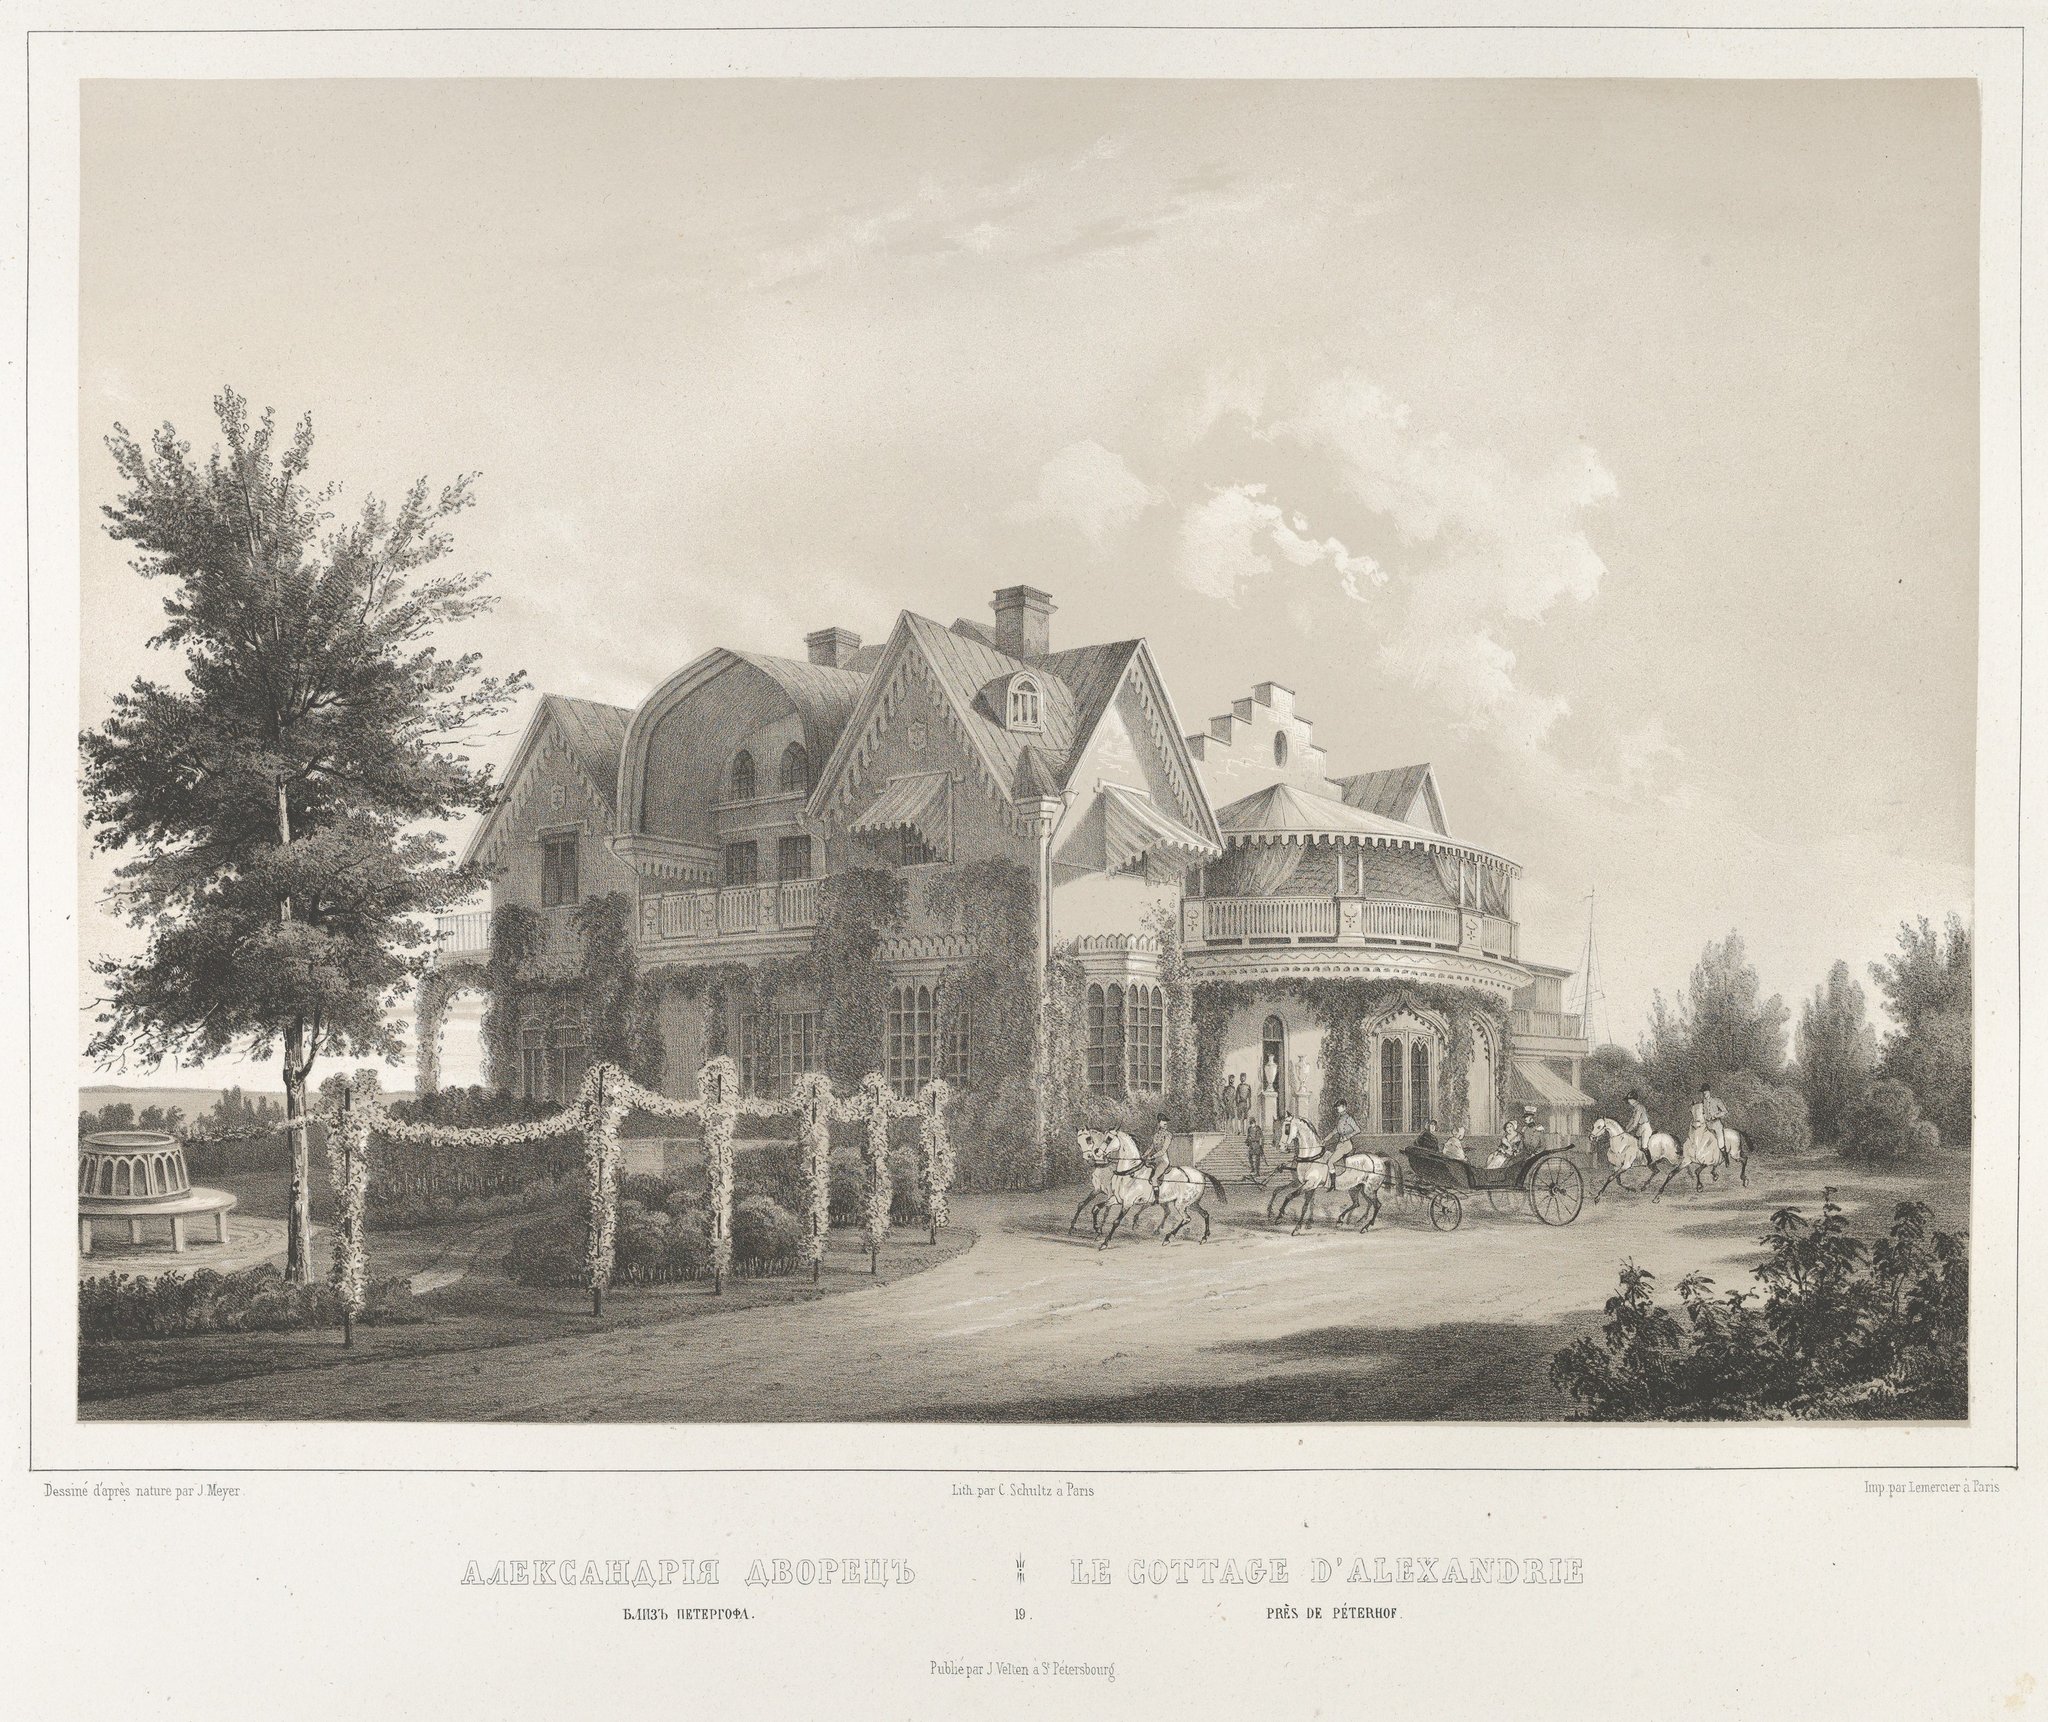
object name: print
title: Le Cottage D'Alexandrie près de Péterof, from "Vues pittoresques des palais & jardins impériaux aux environs de St. Petersbourg"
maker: j. meyer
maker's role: artist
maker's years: 1800-1900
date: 1850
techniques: lithograph, printing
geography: russia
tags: palaces,gardens,men,horses,carriages